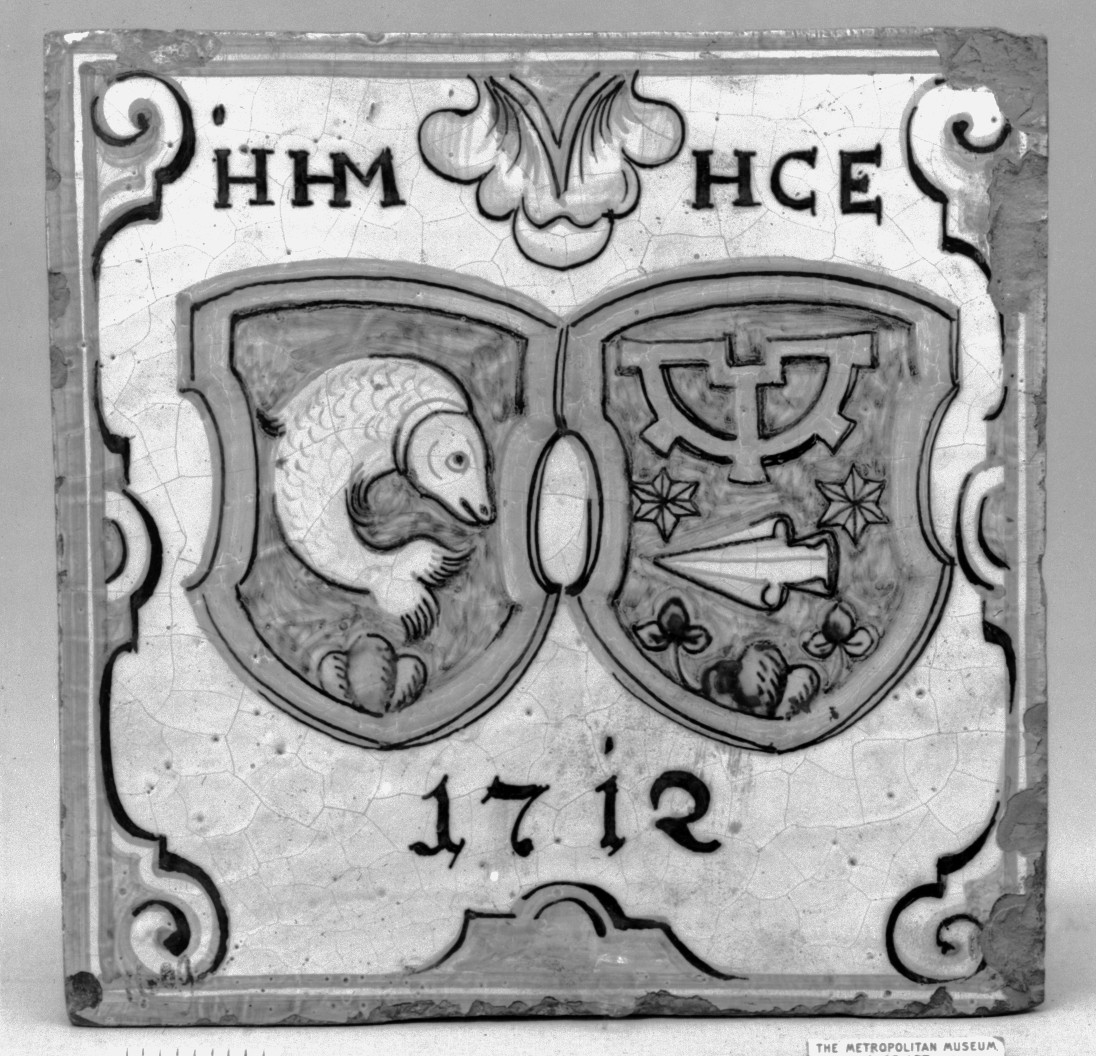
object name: tile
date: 1701-1800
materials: faience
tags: arrowheads,fish